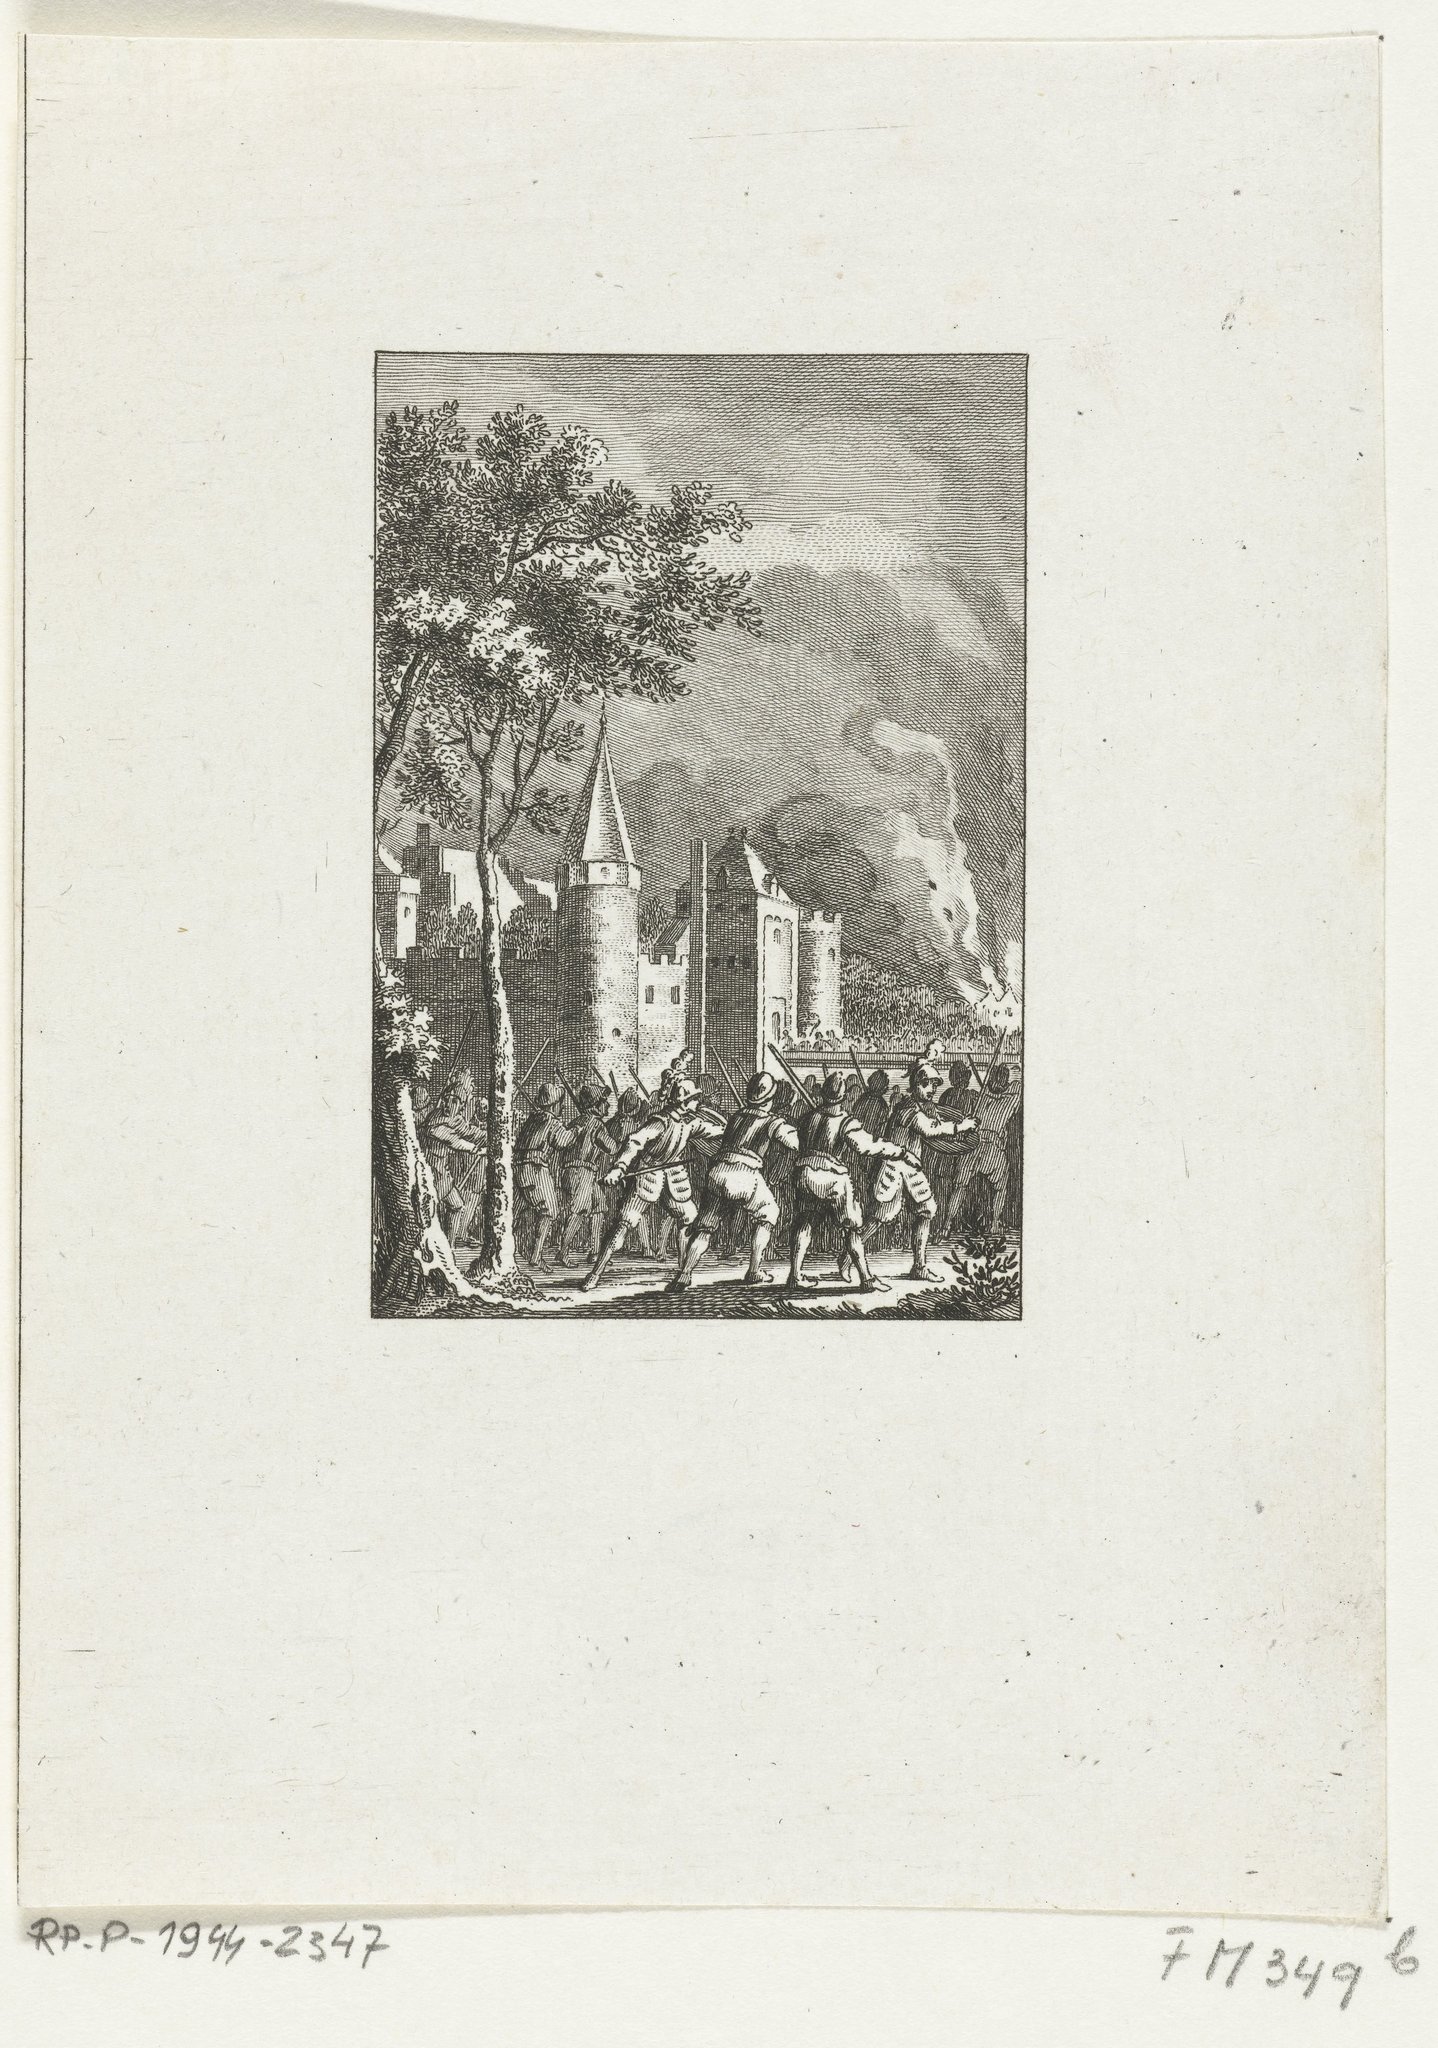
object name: history print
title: Muiderslot door de Geldersen belegerd, 1508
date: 1780-1795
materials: paper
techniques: etching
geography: netherlands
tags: siege, position war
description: Illustratie voor: J. Fokke, Geschiedenissen der Vereenigde Nederlanden voor de vaderlandsche jeugd, Johannes Allart, Amsterdam 1783-1795, 25 delen, dl. III, pl. IV. Staat vóór de letter.